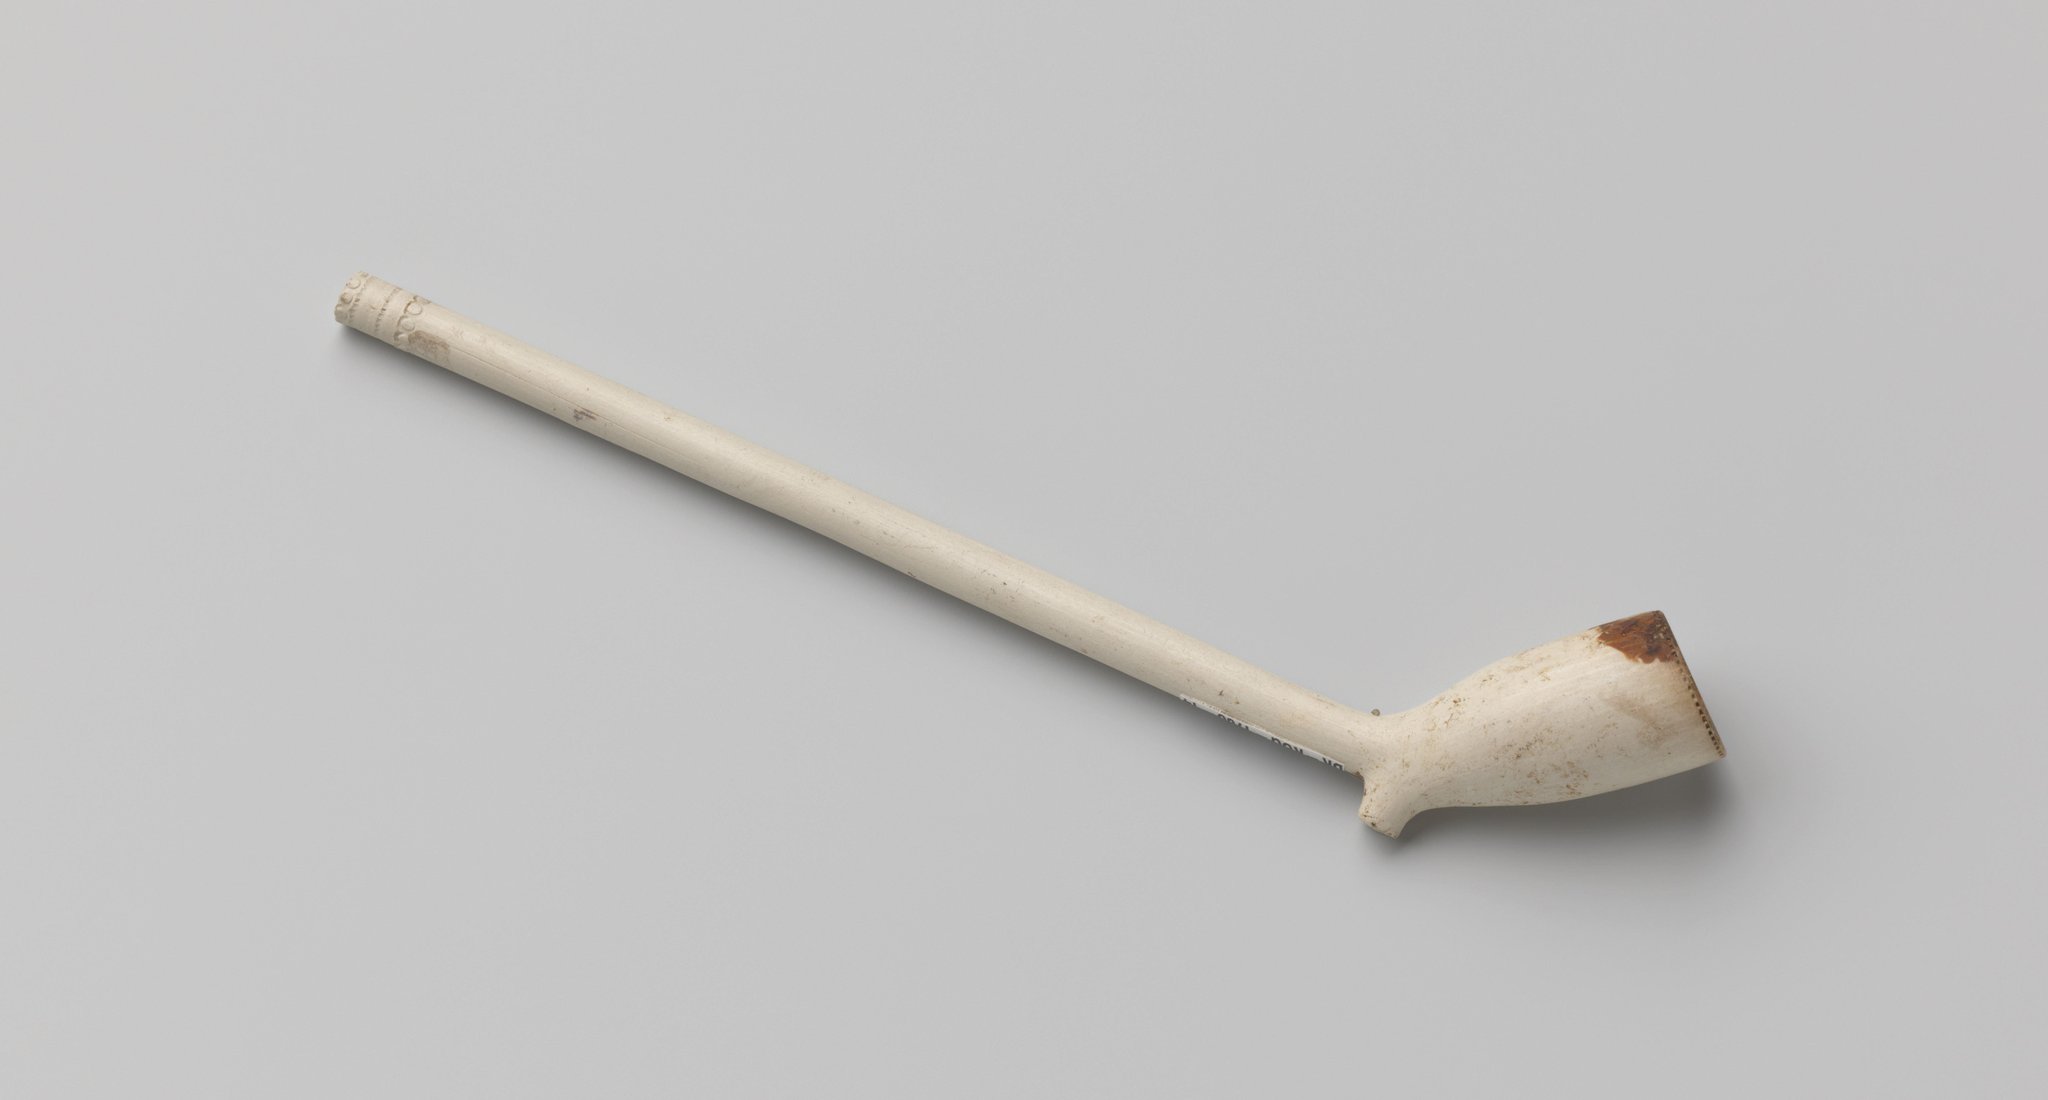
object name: tabakspijp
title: Gemerkte tabakspijp van pijpaarde, beschadigd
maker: Anonymous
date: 1500-1799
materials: clay